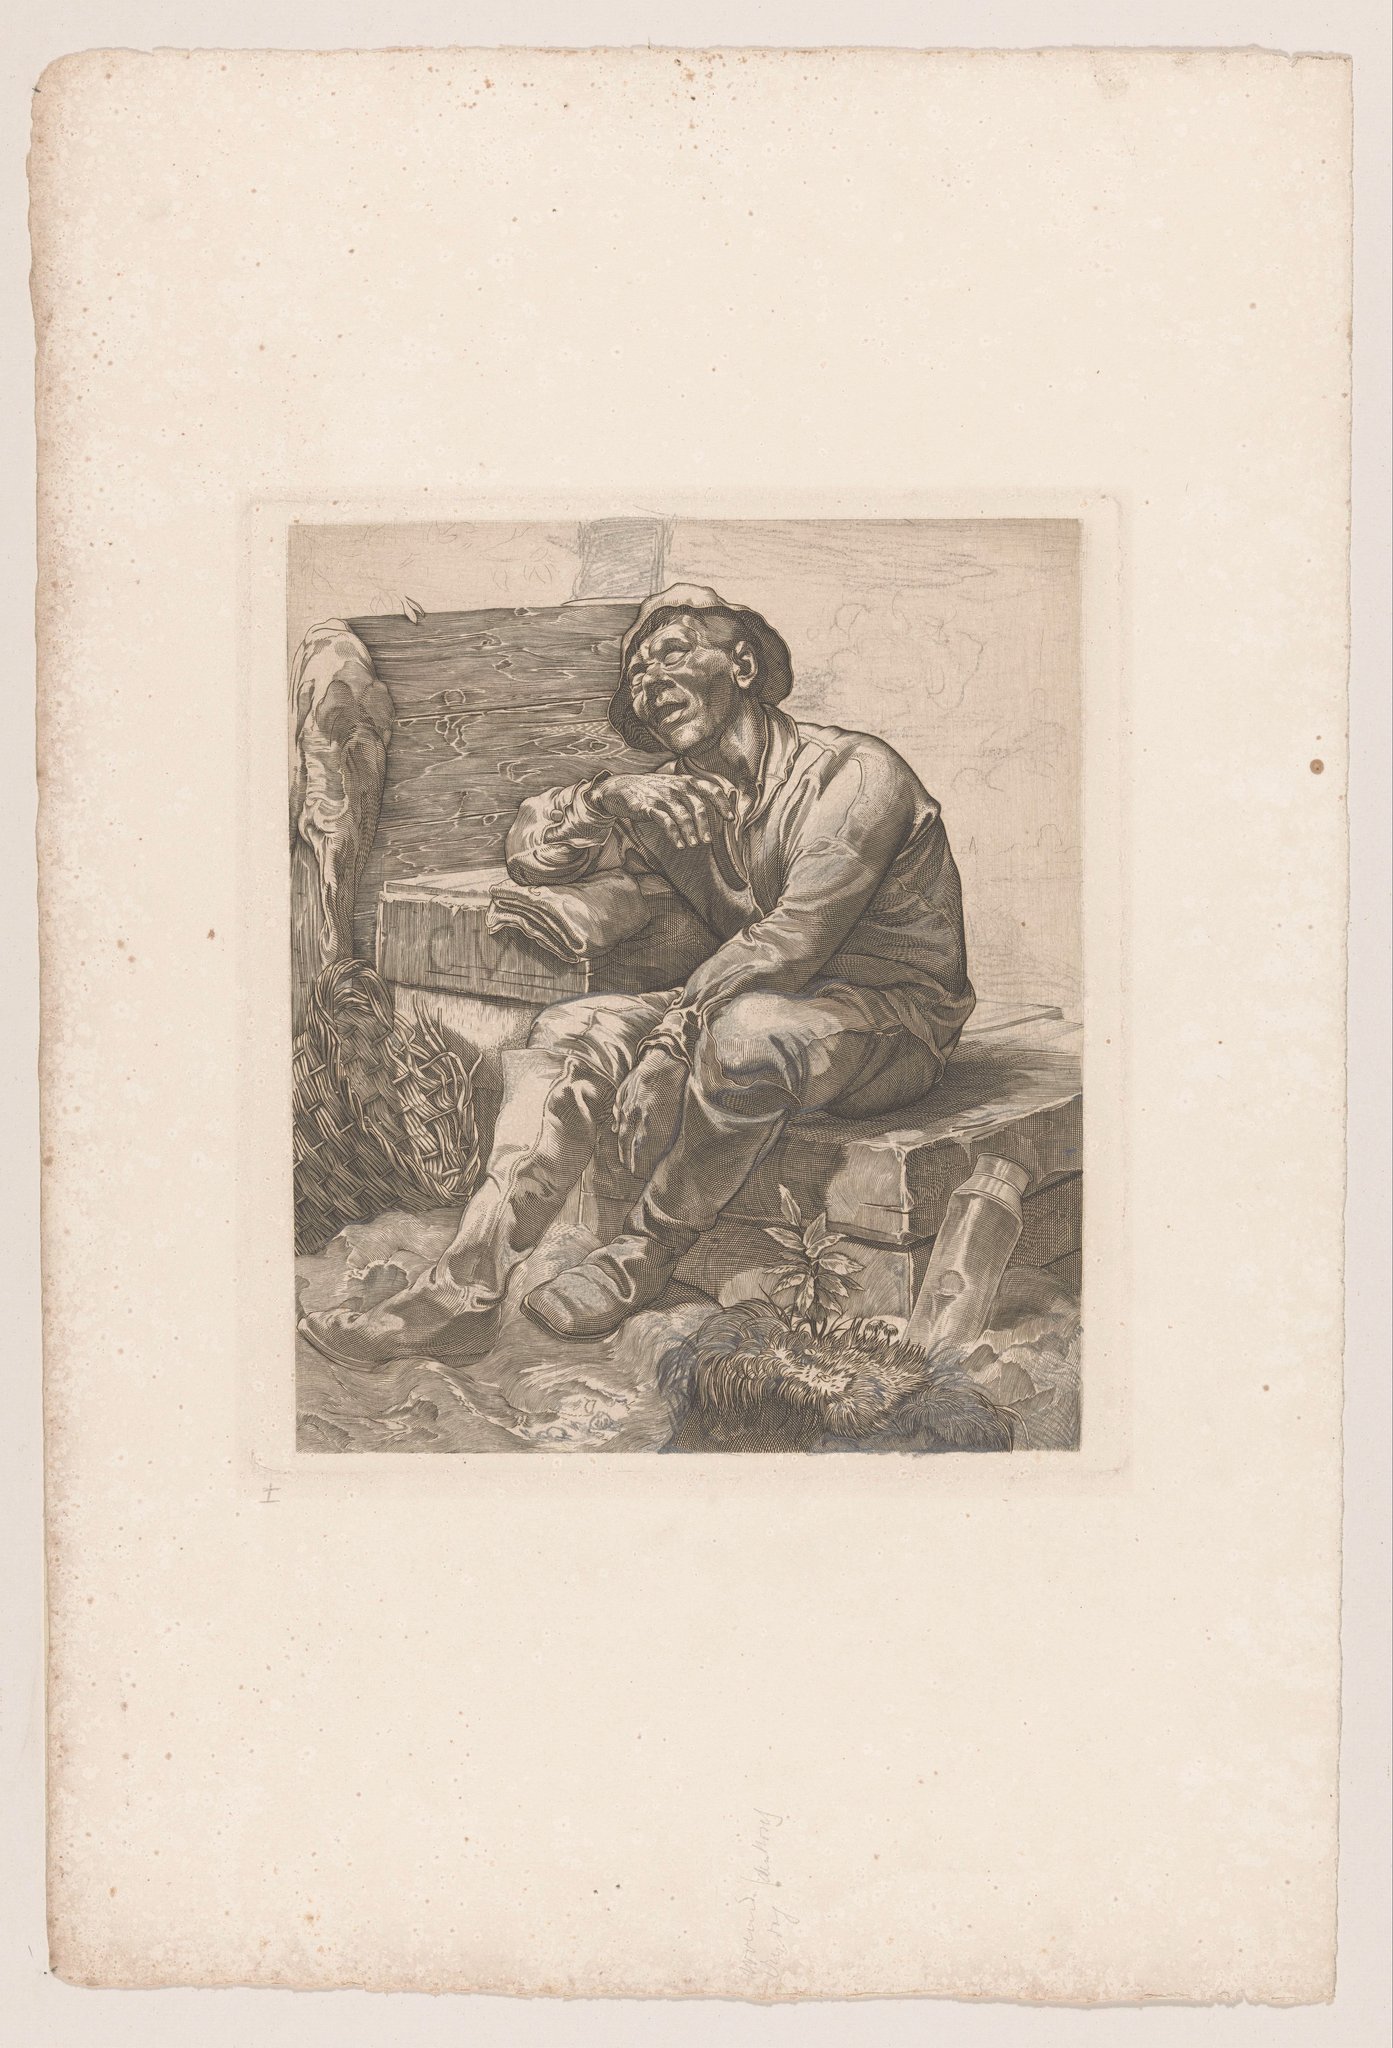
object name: print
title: Slapende polderjongen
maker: johannes josephus aarts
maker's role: draughtsman, print maker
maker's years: 1871-1934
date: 1881-1934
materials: chalk, paper, pencil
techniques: engraving, intaglio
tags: sleeping; unconsciousness - bb - out of doors, working class, labourers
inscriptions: annotation: ‘woensd vrijdag: den haag’, collector's mark: Lugt 2760, collector's mark: Lugt 2166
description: Een man in werkkleding en met hoed, zittend en slapend op een houten bank. Linksboven een tak met bladeren, rechtsonder een drinkfles. Rechts op de achtergrond een nederzetting met kerktoren.